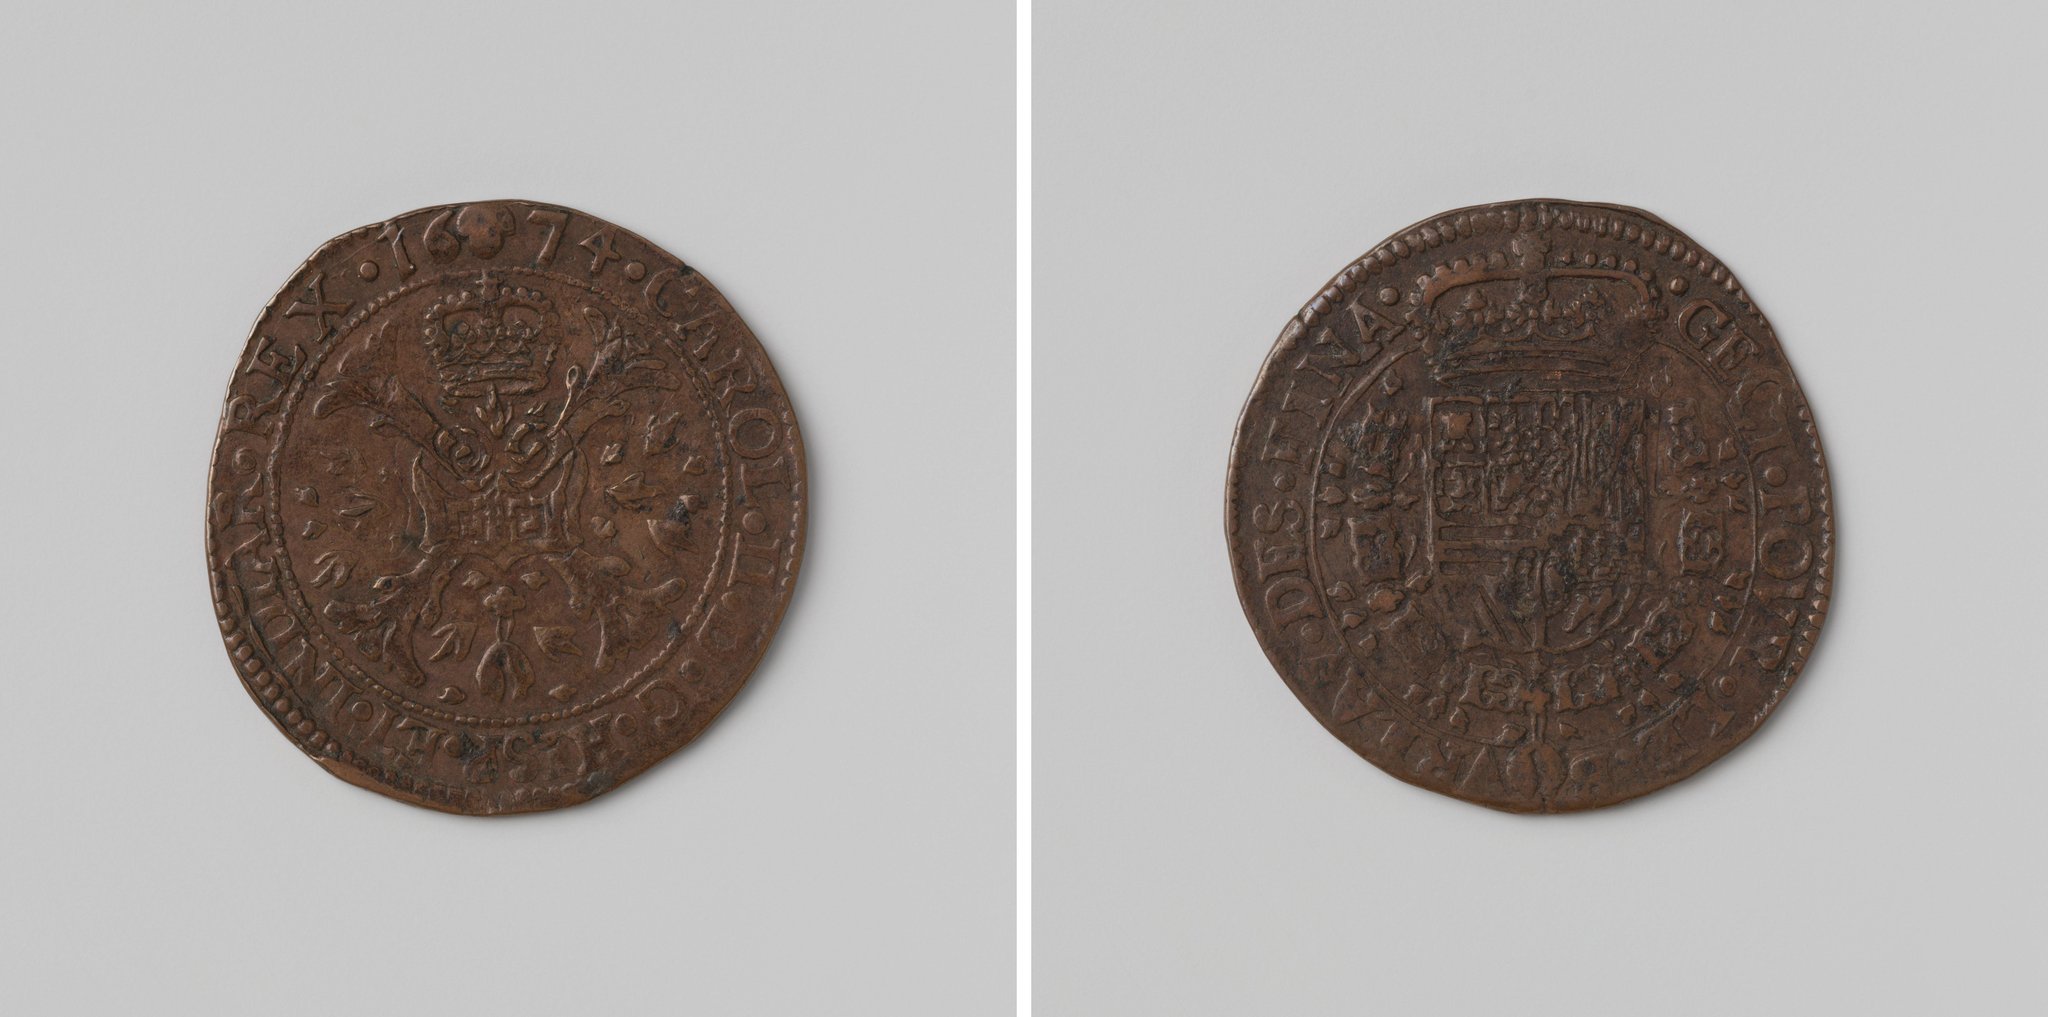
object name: jeton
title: Karel II, koning van Spanje, rekenpenning geslagen op last van de raad van Financiën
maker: Anonymous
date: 1674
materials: copper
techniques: striking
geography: brussels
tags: karel ii (koning van spanje)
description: Koperen penning. Voorzijde: vuurslag onder kroon op Bourgondisch kruis, omgeven door vonken; daaronder: vuursteen, waar vonken uitschieten binnen omschrift. Keerzijde: gekroond wapenschild, omhangen met de orde van het Gulden Vlies binnen omschrift